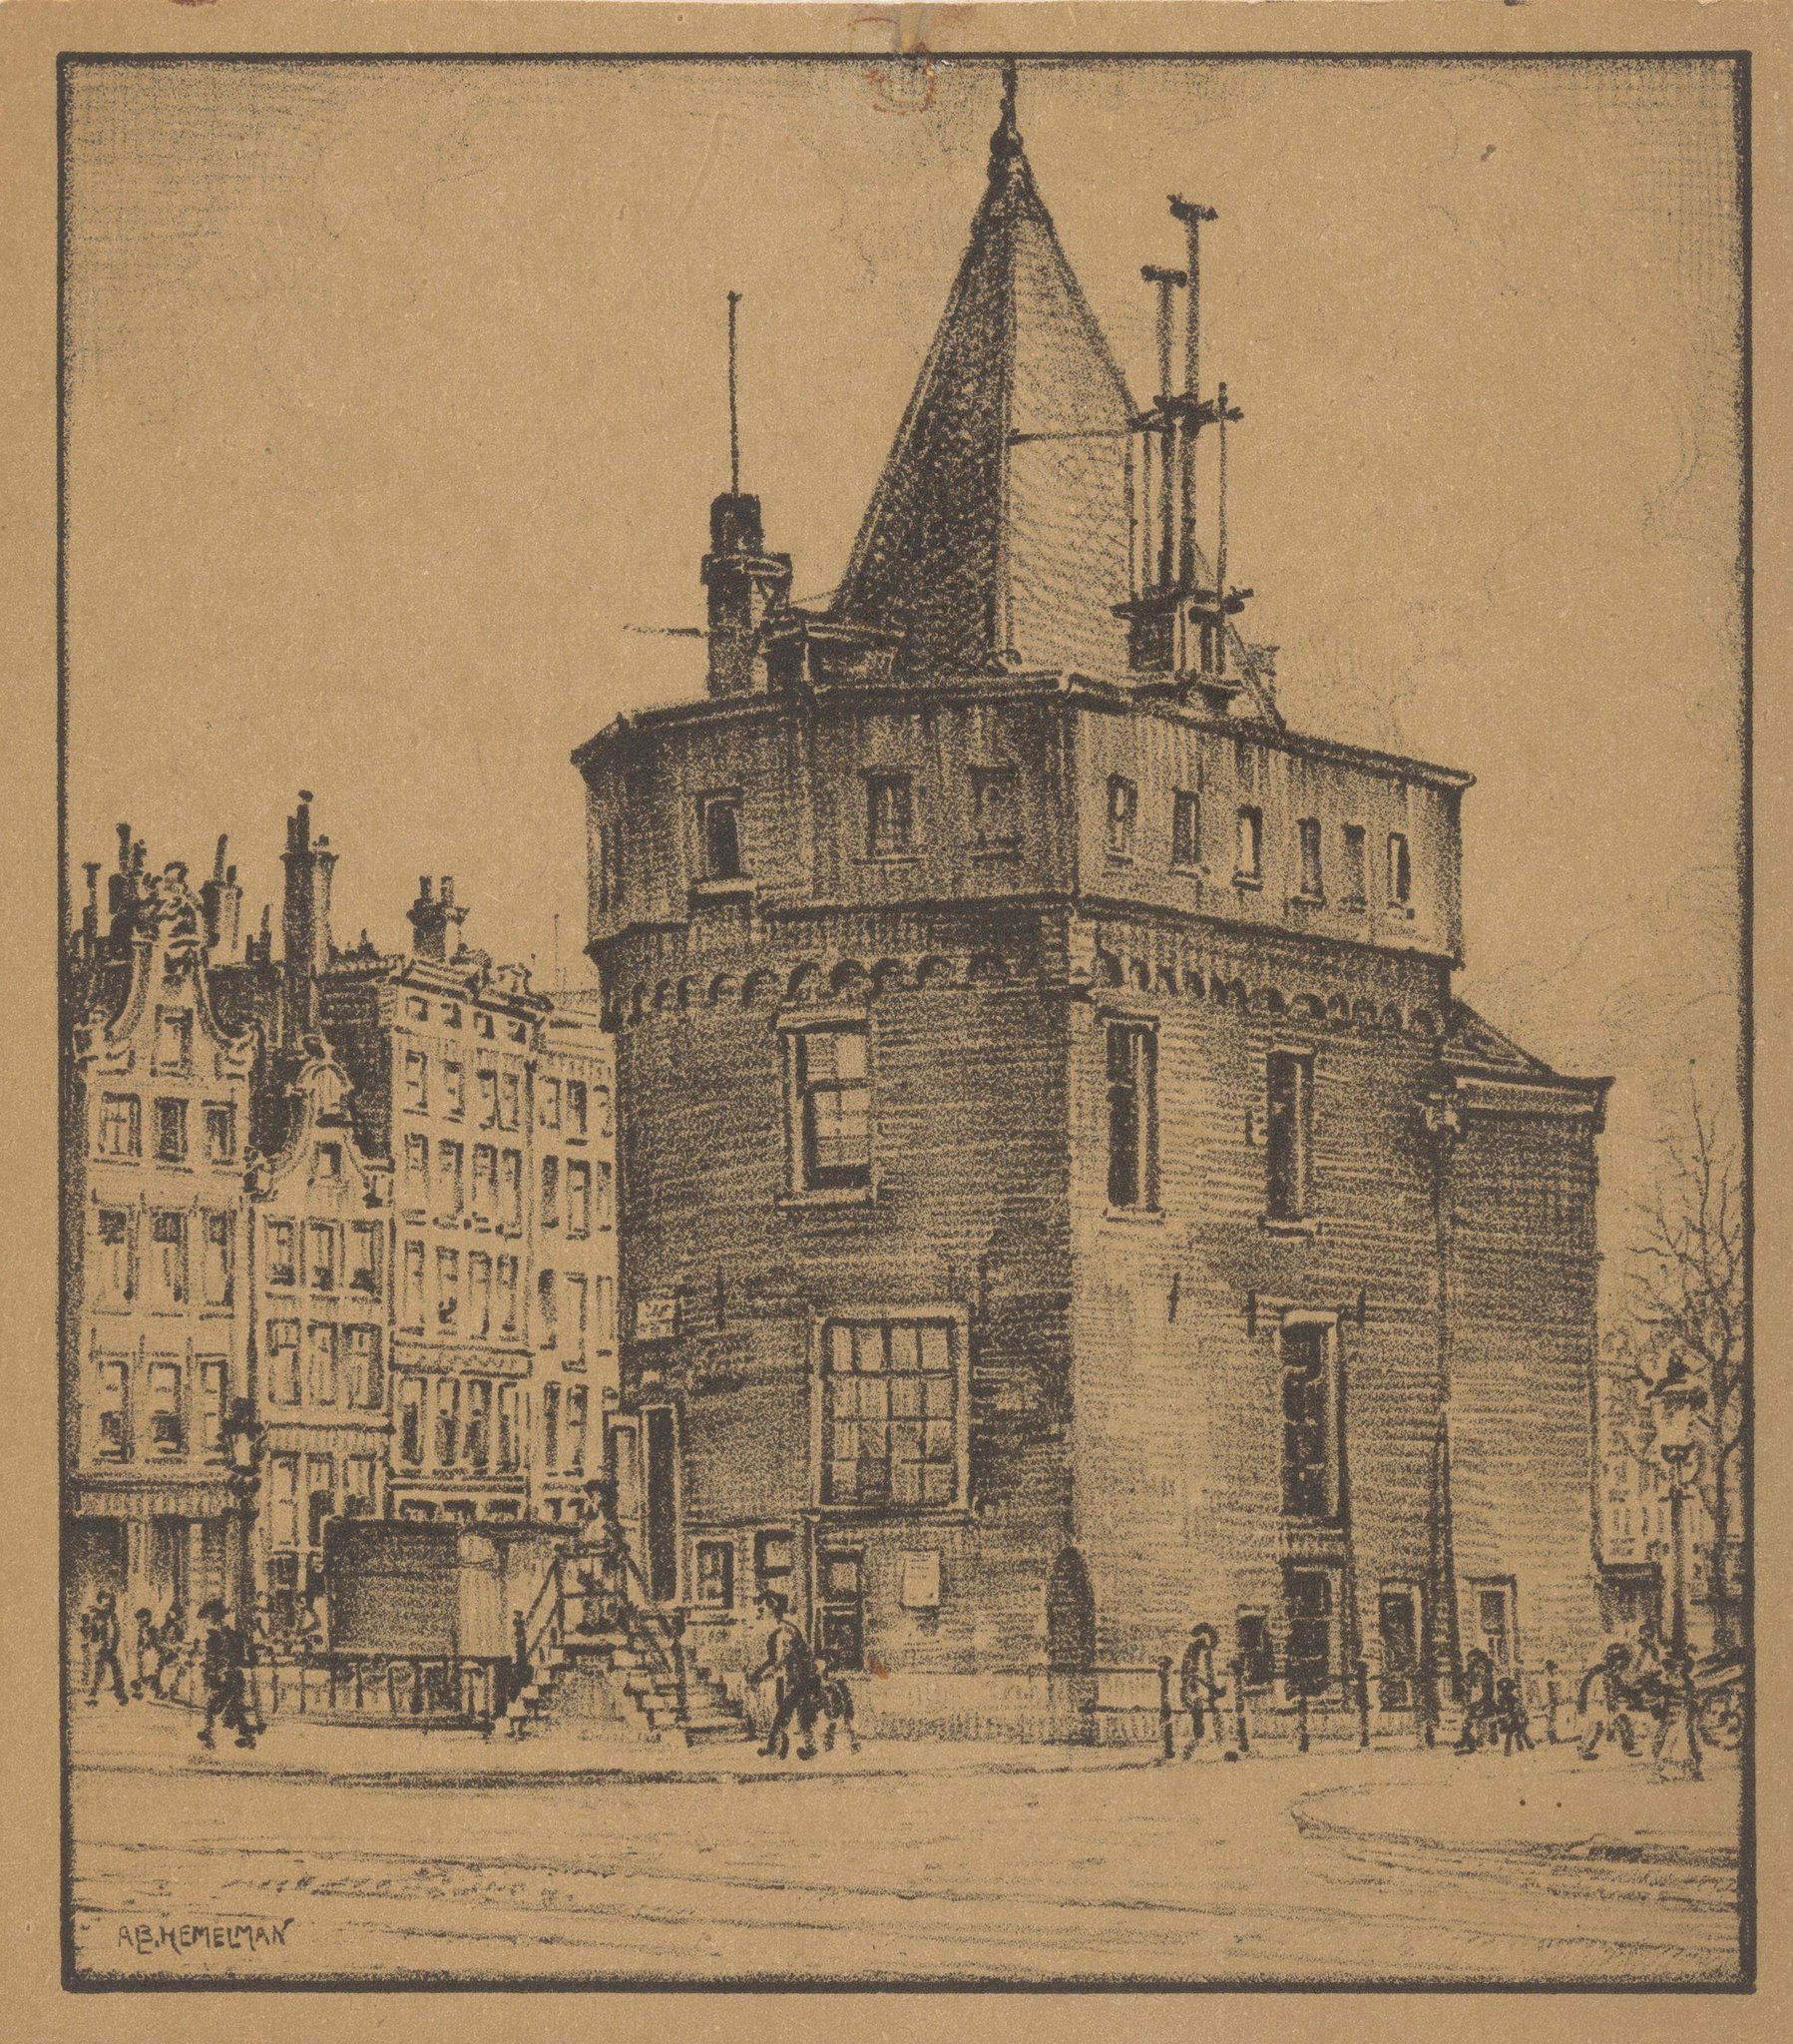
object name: print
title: Schreierstoren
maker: albert hemelman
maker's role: draughtsman, print maker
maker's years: 1883-1951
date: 1902-1951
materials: paper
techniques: lithograph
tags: city-view in general; 'veduta' (+ city(-scape) with figures, staffage)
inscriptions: signature: ‘ALB HEMELMAN’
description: Schreierstoren met op de achtergrond gevels.